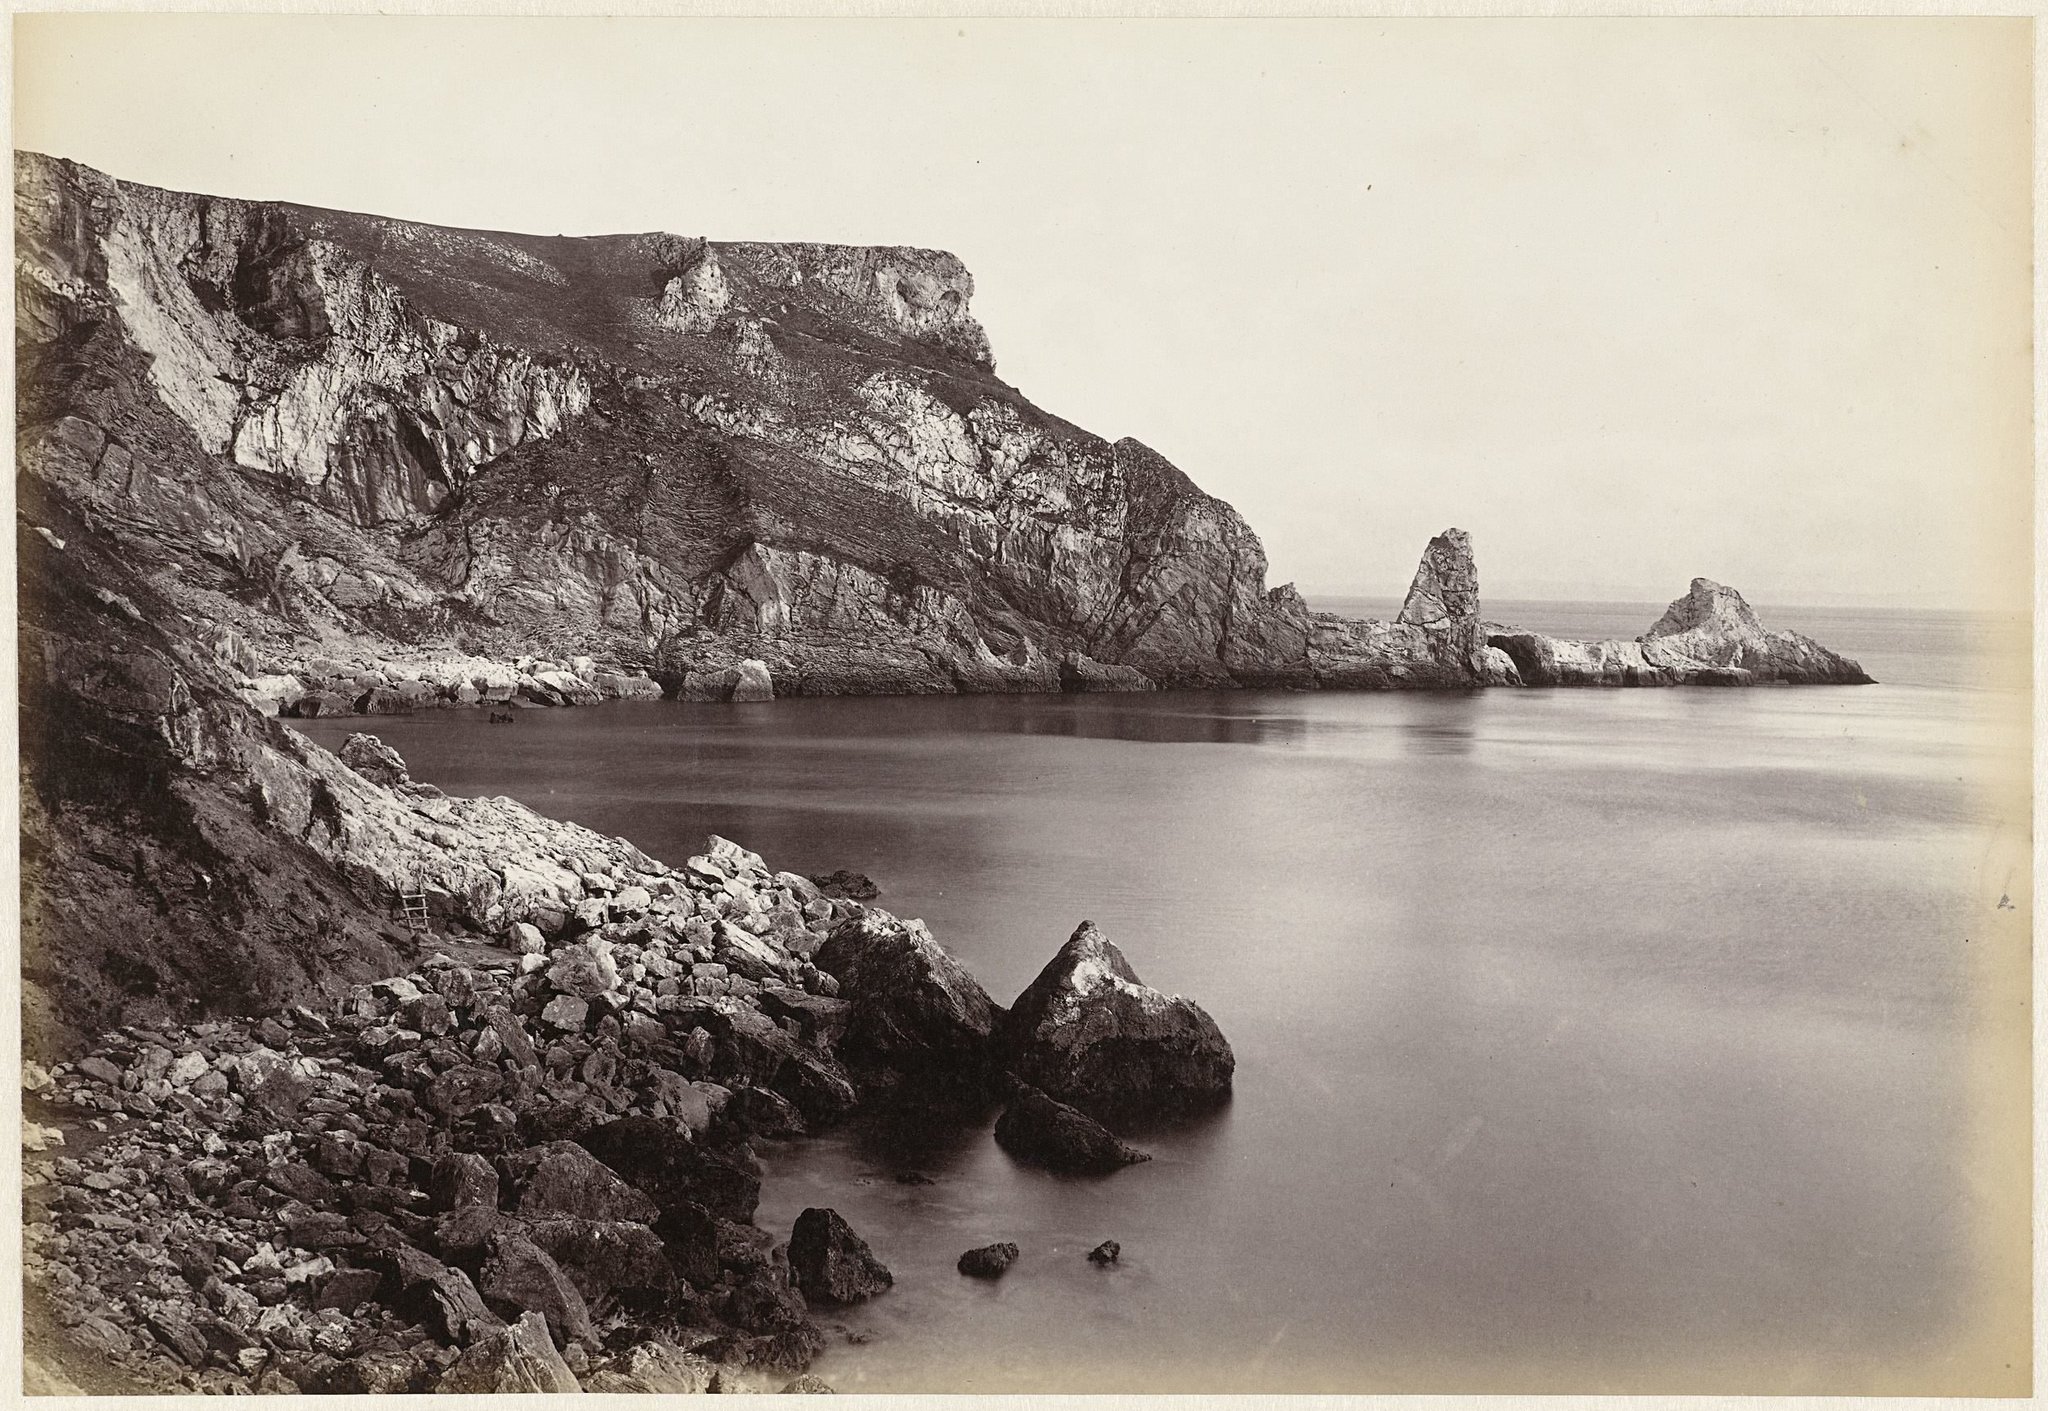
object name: photograph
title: Rotskust in Groot-Brittannië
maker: Anonymous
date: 1851-1900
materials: paper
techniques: albumen print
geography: great britain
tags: coastal cliff or crag, great britain